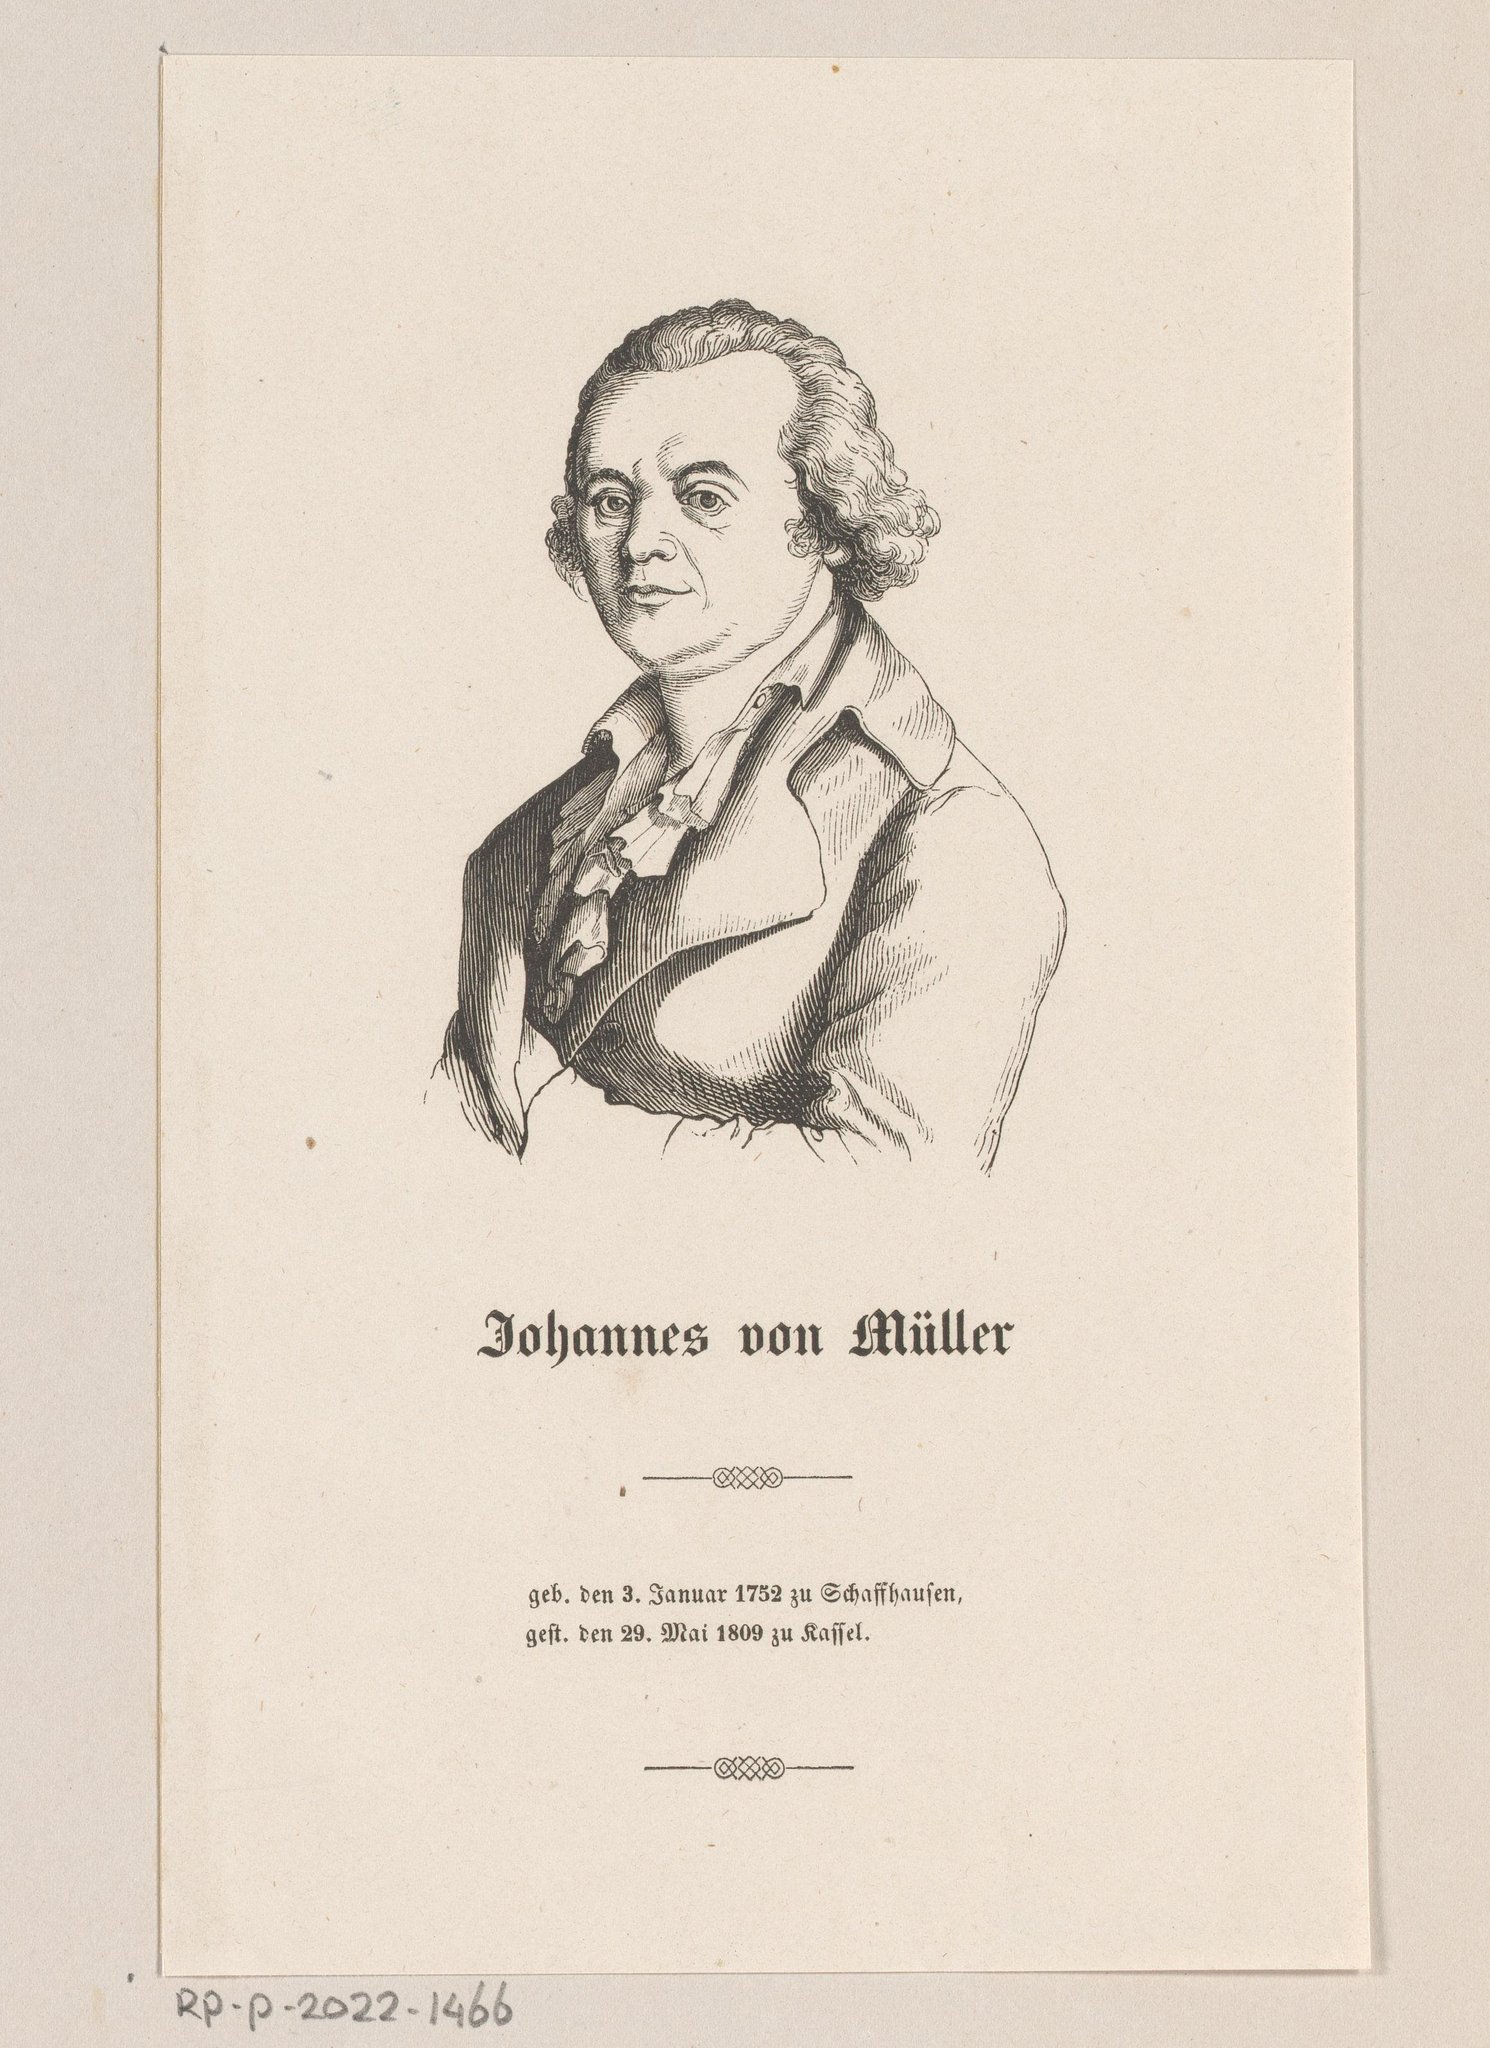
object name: print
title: Johannes von Müller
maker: Anonymous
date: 1854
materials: paper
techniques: letterpress printing, engraving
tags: further education (+ portrait of teacher, professor), historical persons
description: Prent waarschijnlijk uit: Scherr, Johannes. Geschichte der deutschen Literatur (...). Leipzig: Otto Migand, 1854.